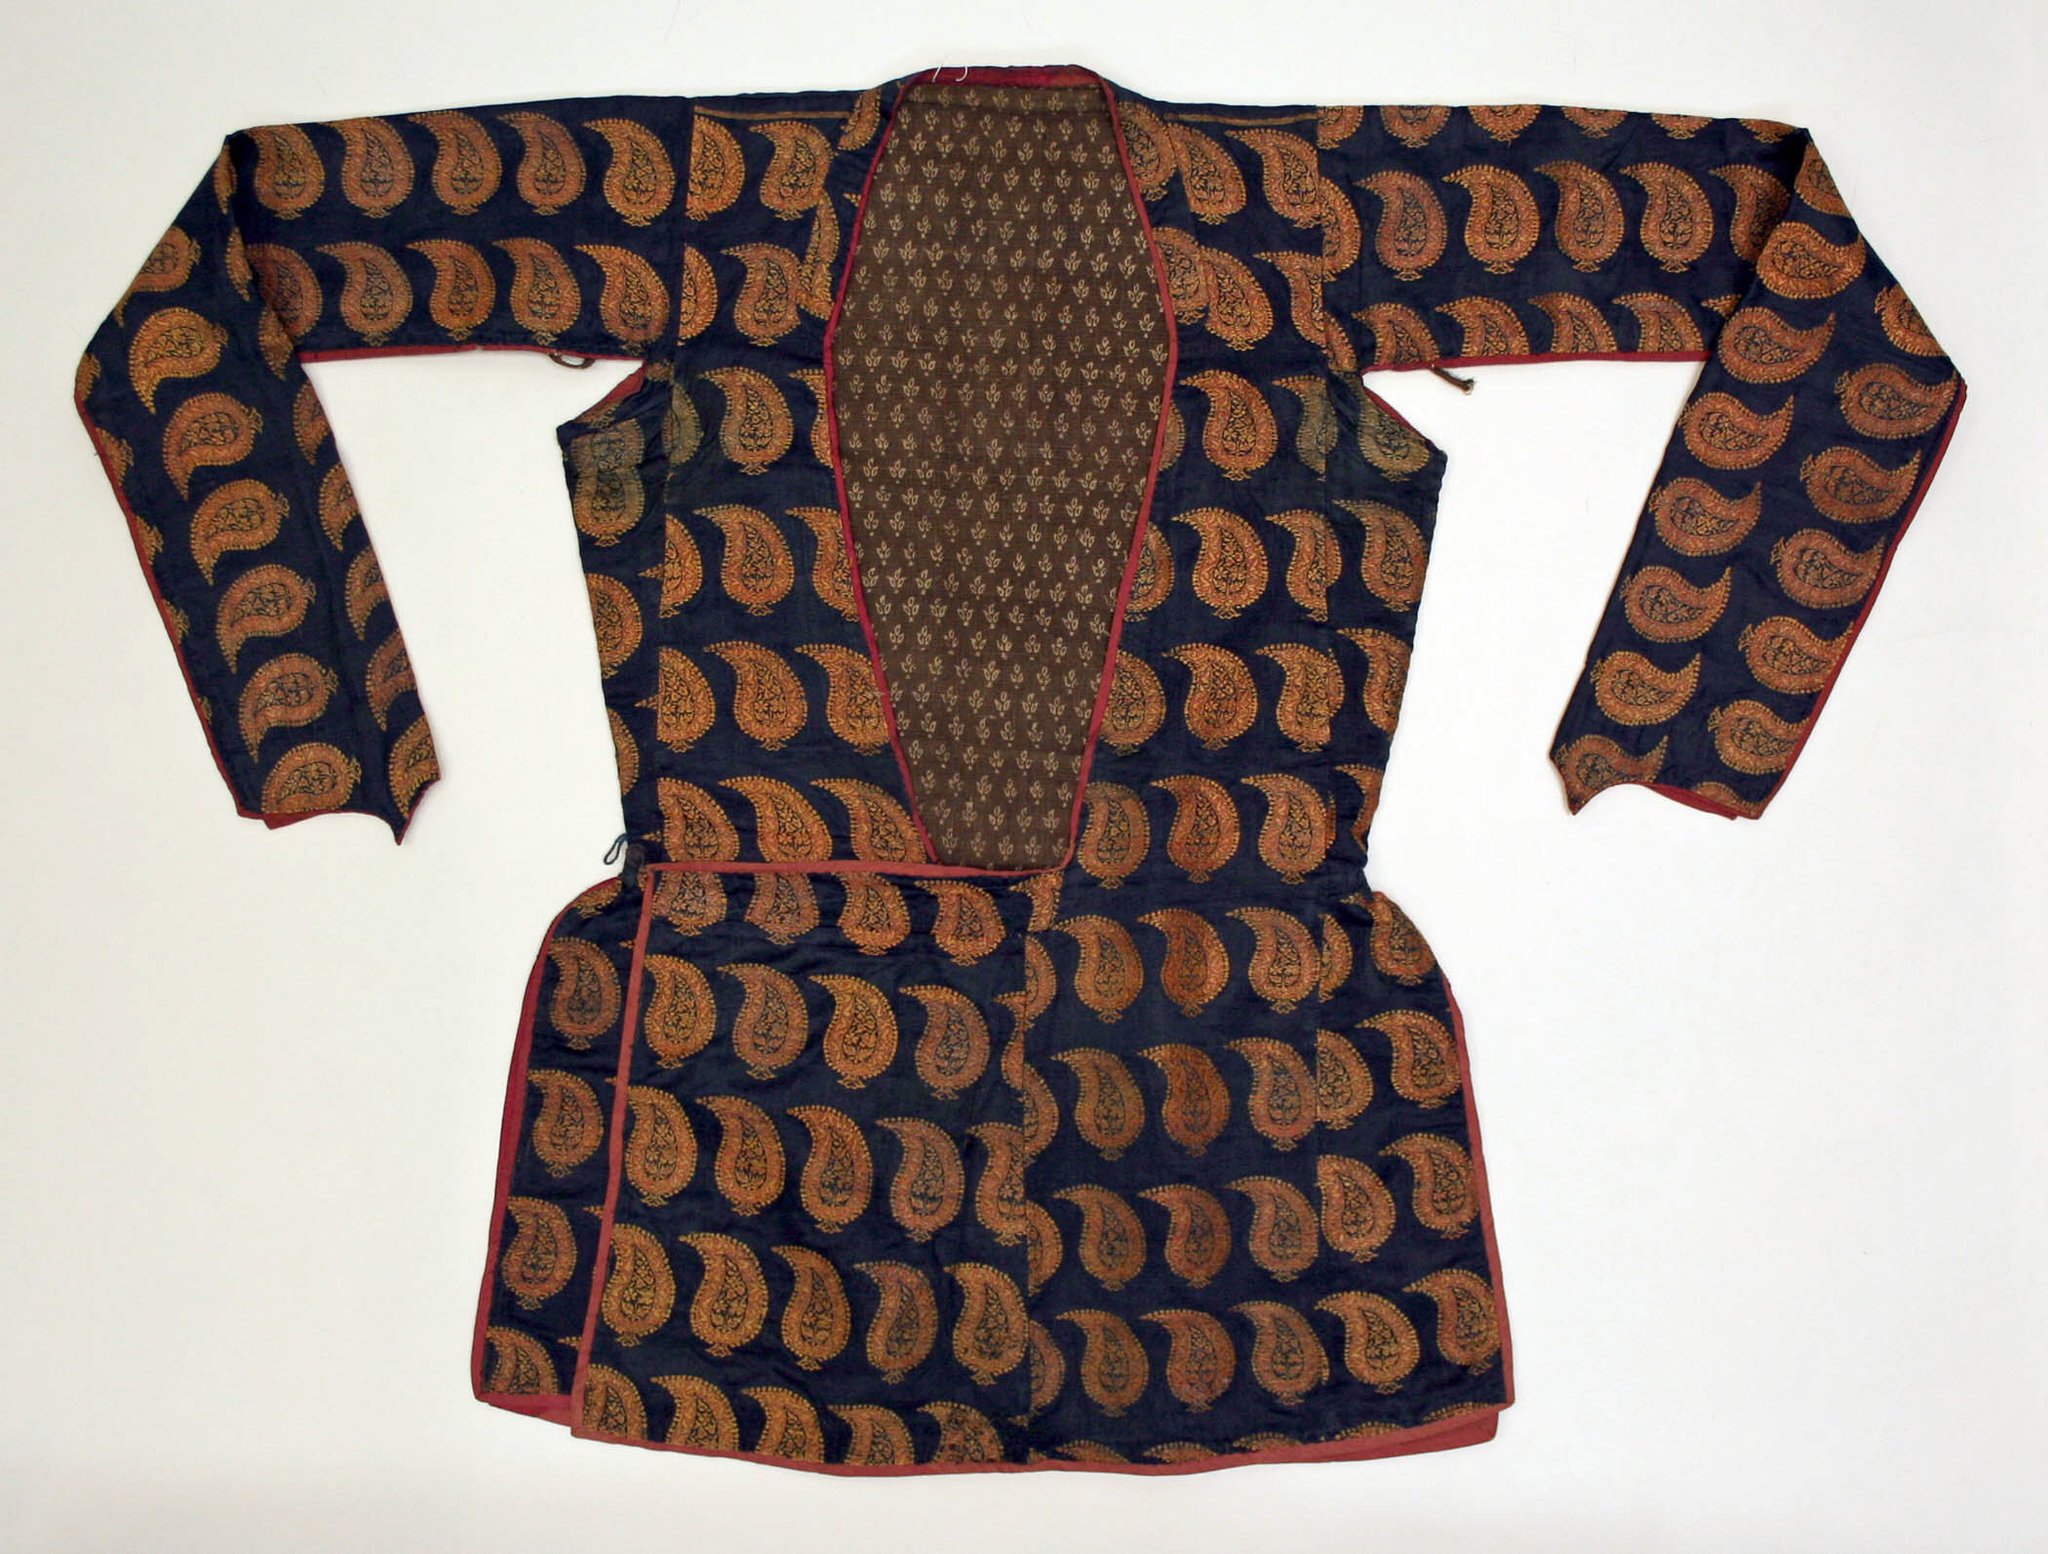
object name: jacket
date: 1801-1900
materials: cotton, metal thread, silk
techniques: brocade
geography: iran